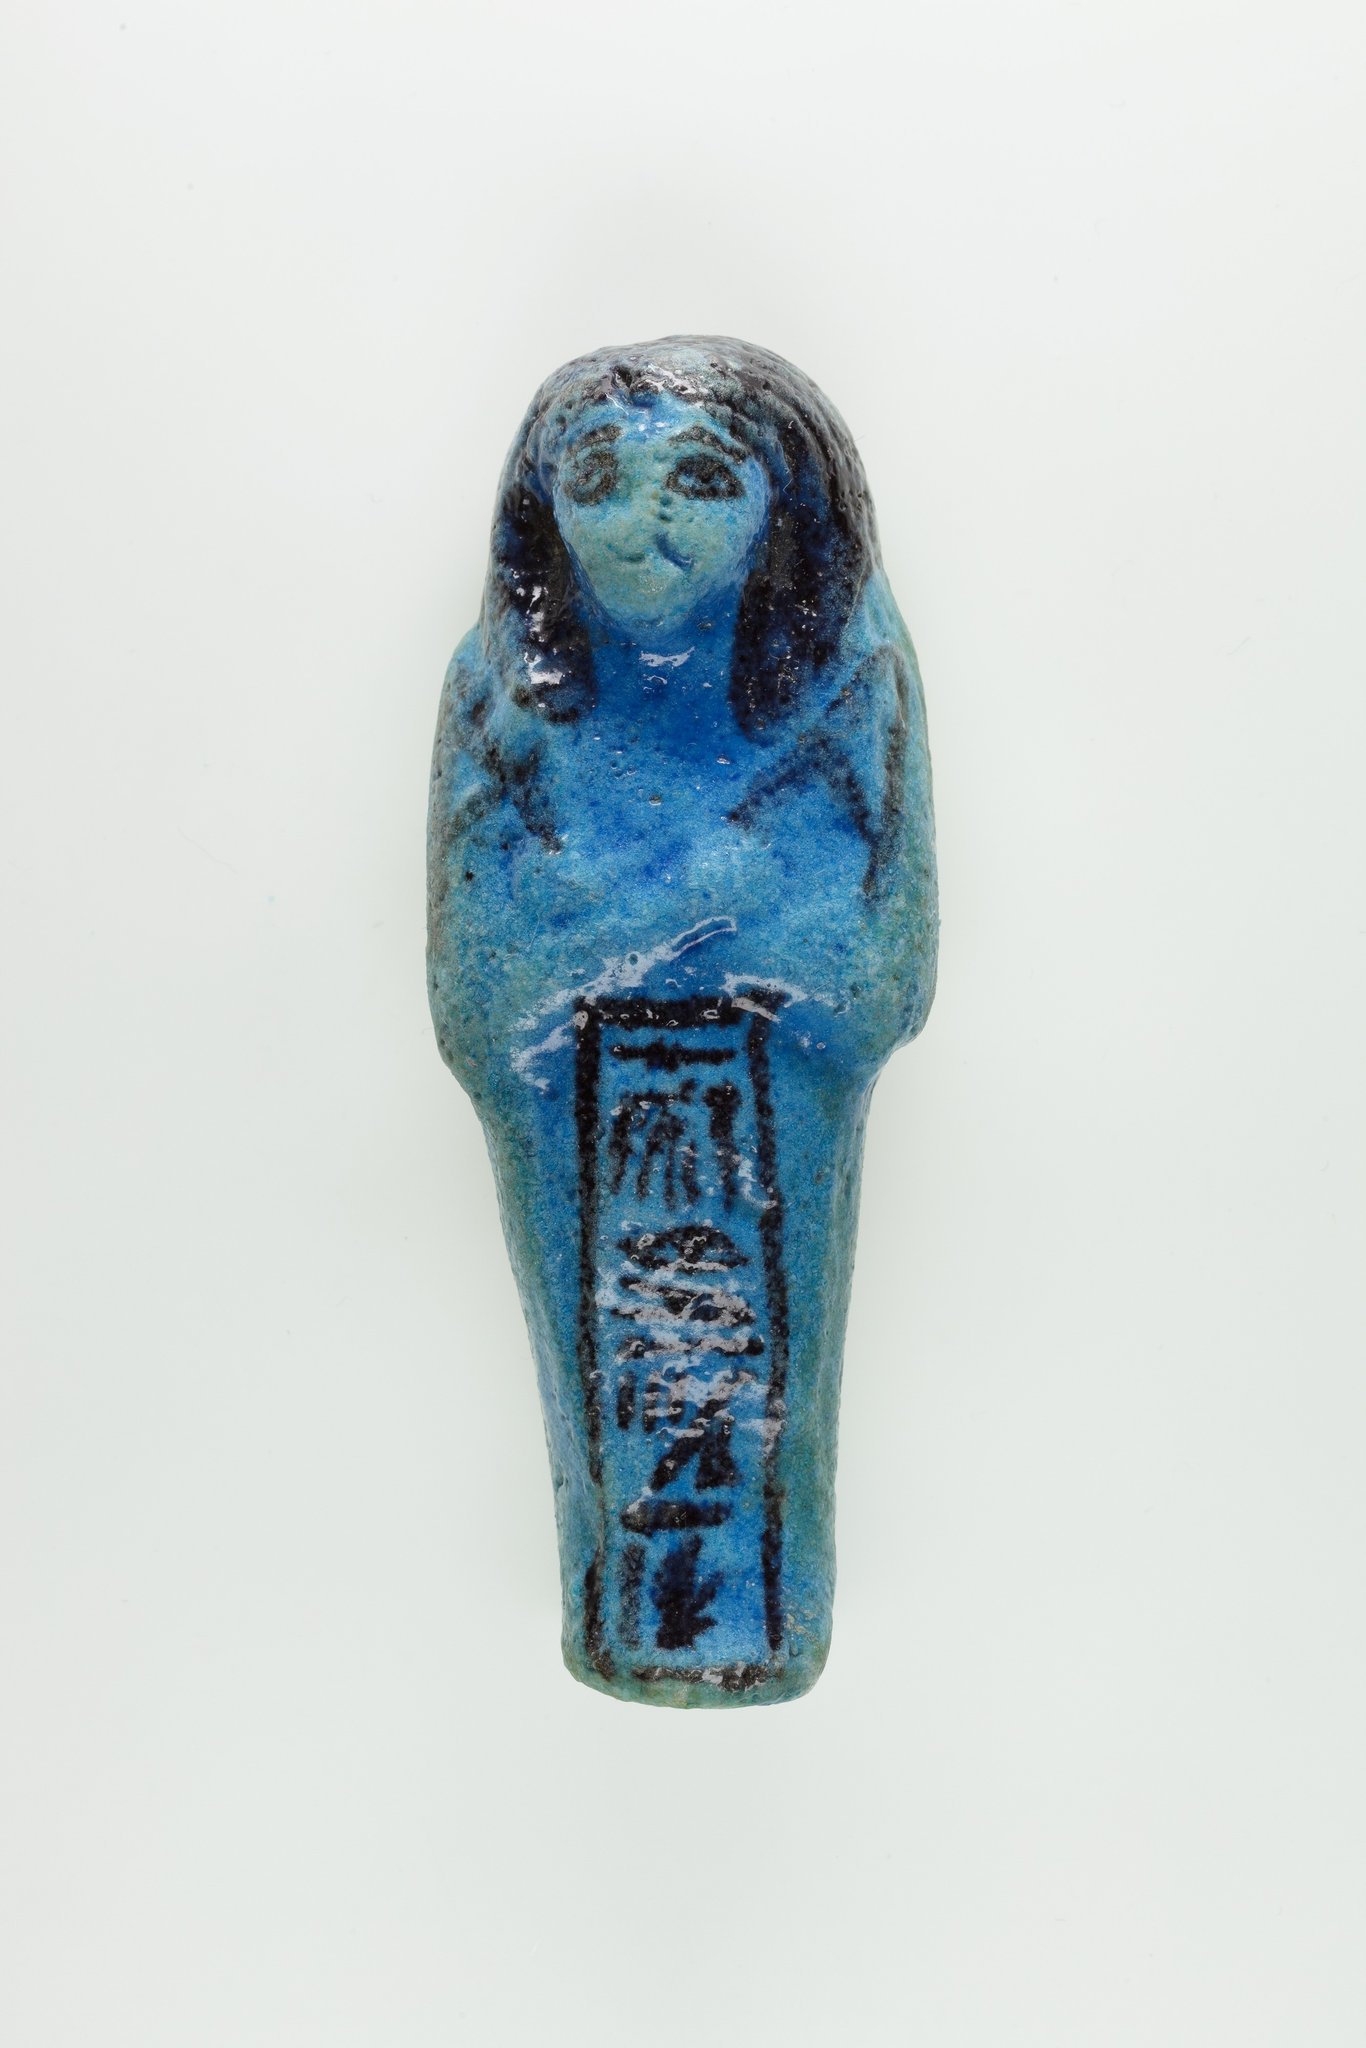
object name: shabti, worker, nauny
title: Worker Shabti of Nauny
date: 1050 BCE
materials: faience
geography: egypt